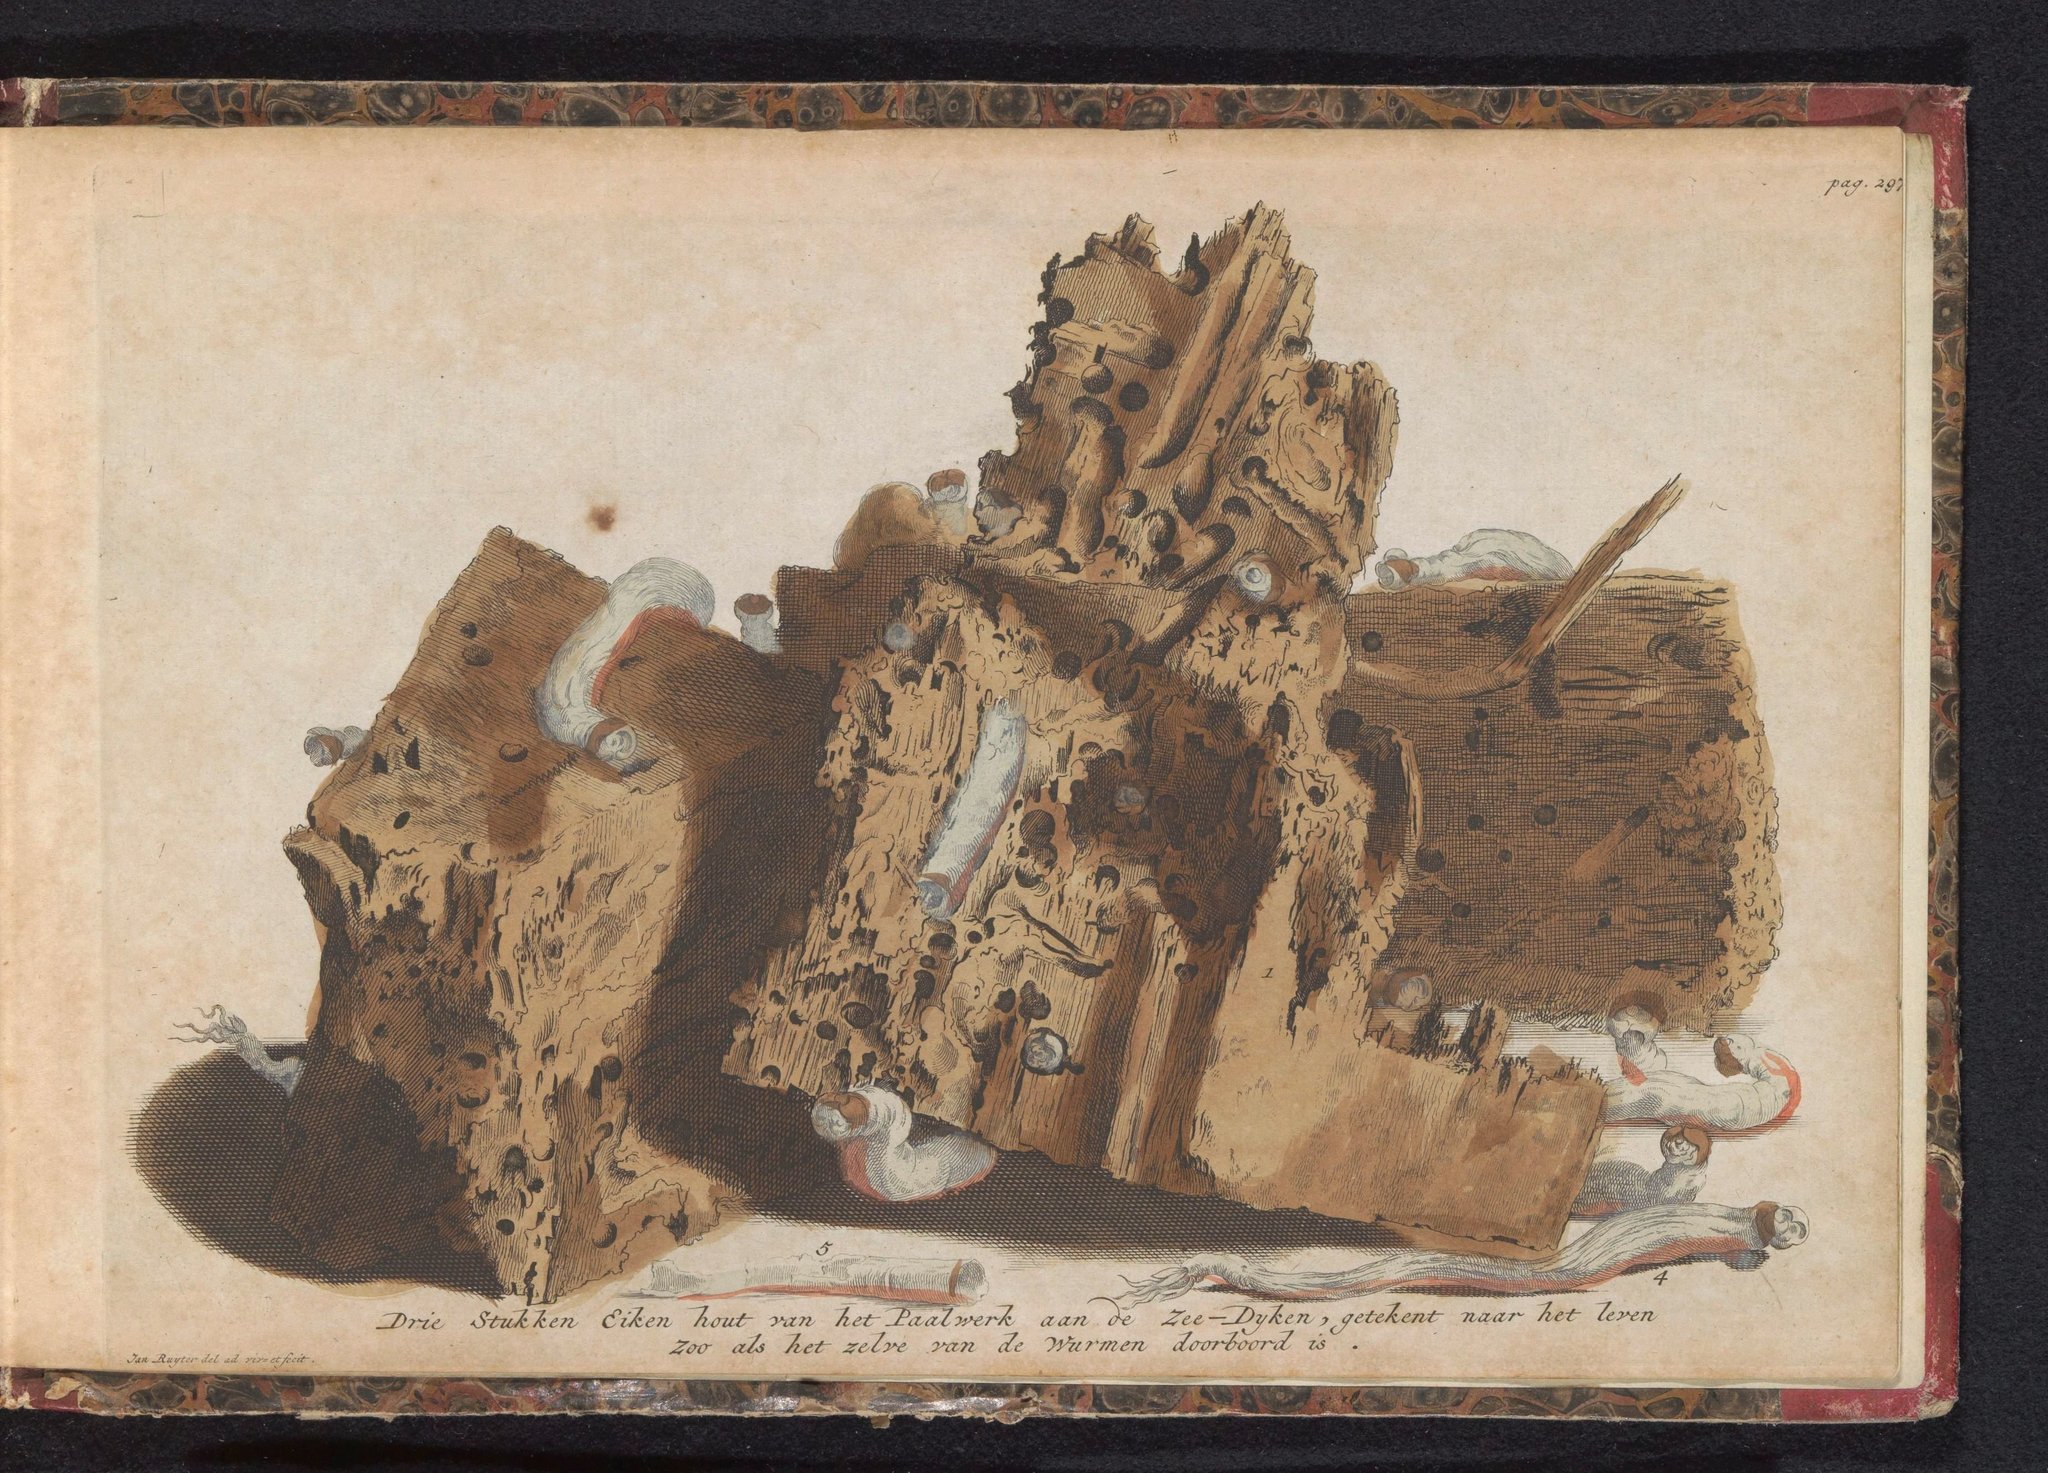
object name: print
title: Drie Stukken Eiken hout van het Paalwerk aan de Zee-Dyken, getekent naar het leven zoo als het zelve van de Wurmen doorboord is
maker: johannes de ruijter (1688-1744)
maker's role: print maker, publisher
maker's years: 1688-1744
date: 1731-1735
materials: paper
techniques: engraving, etching, hand coloring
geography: amsterdam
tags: worms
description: Enkele delen van het paalwerk van de dijkbeschoeiïngen aangetast door paalwormen in 1731. Gemerkt rechtsboven: pag. 297. Onderdeel van een atlas met 223 kaarten van landen en steden en oorlogstaferelen in Europa in de periode ca. 1690-1735.